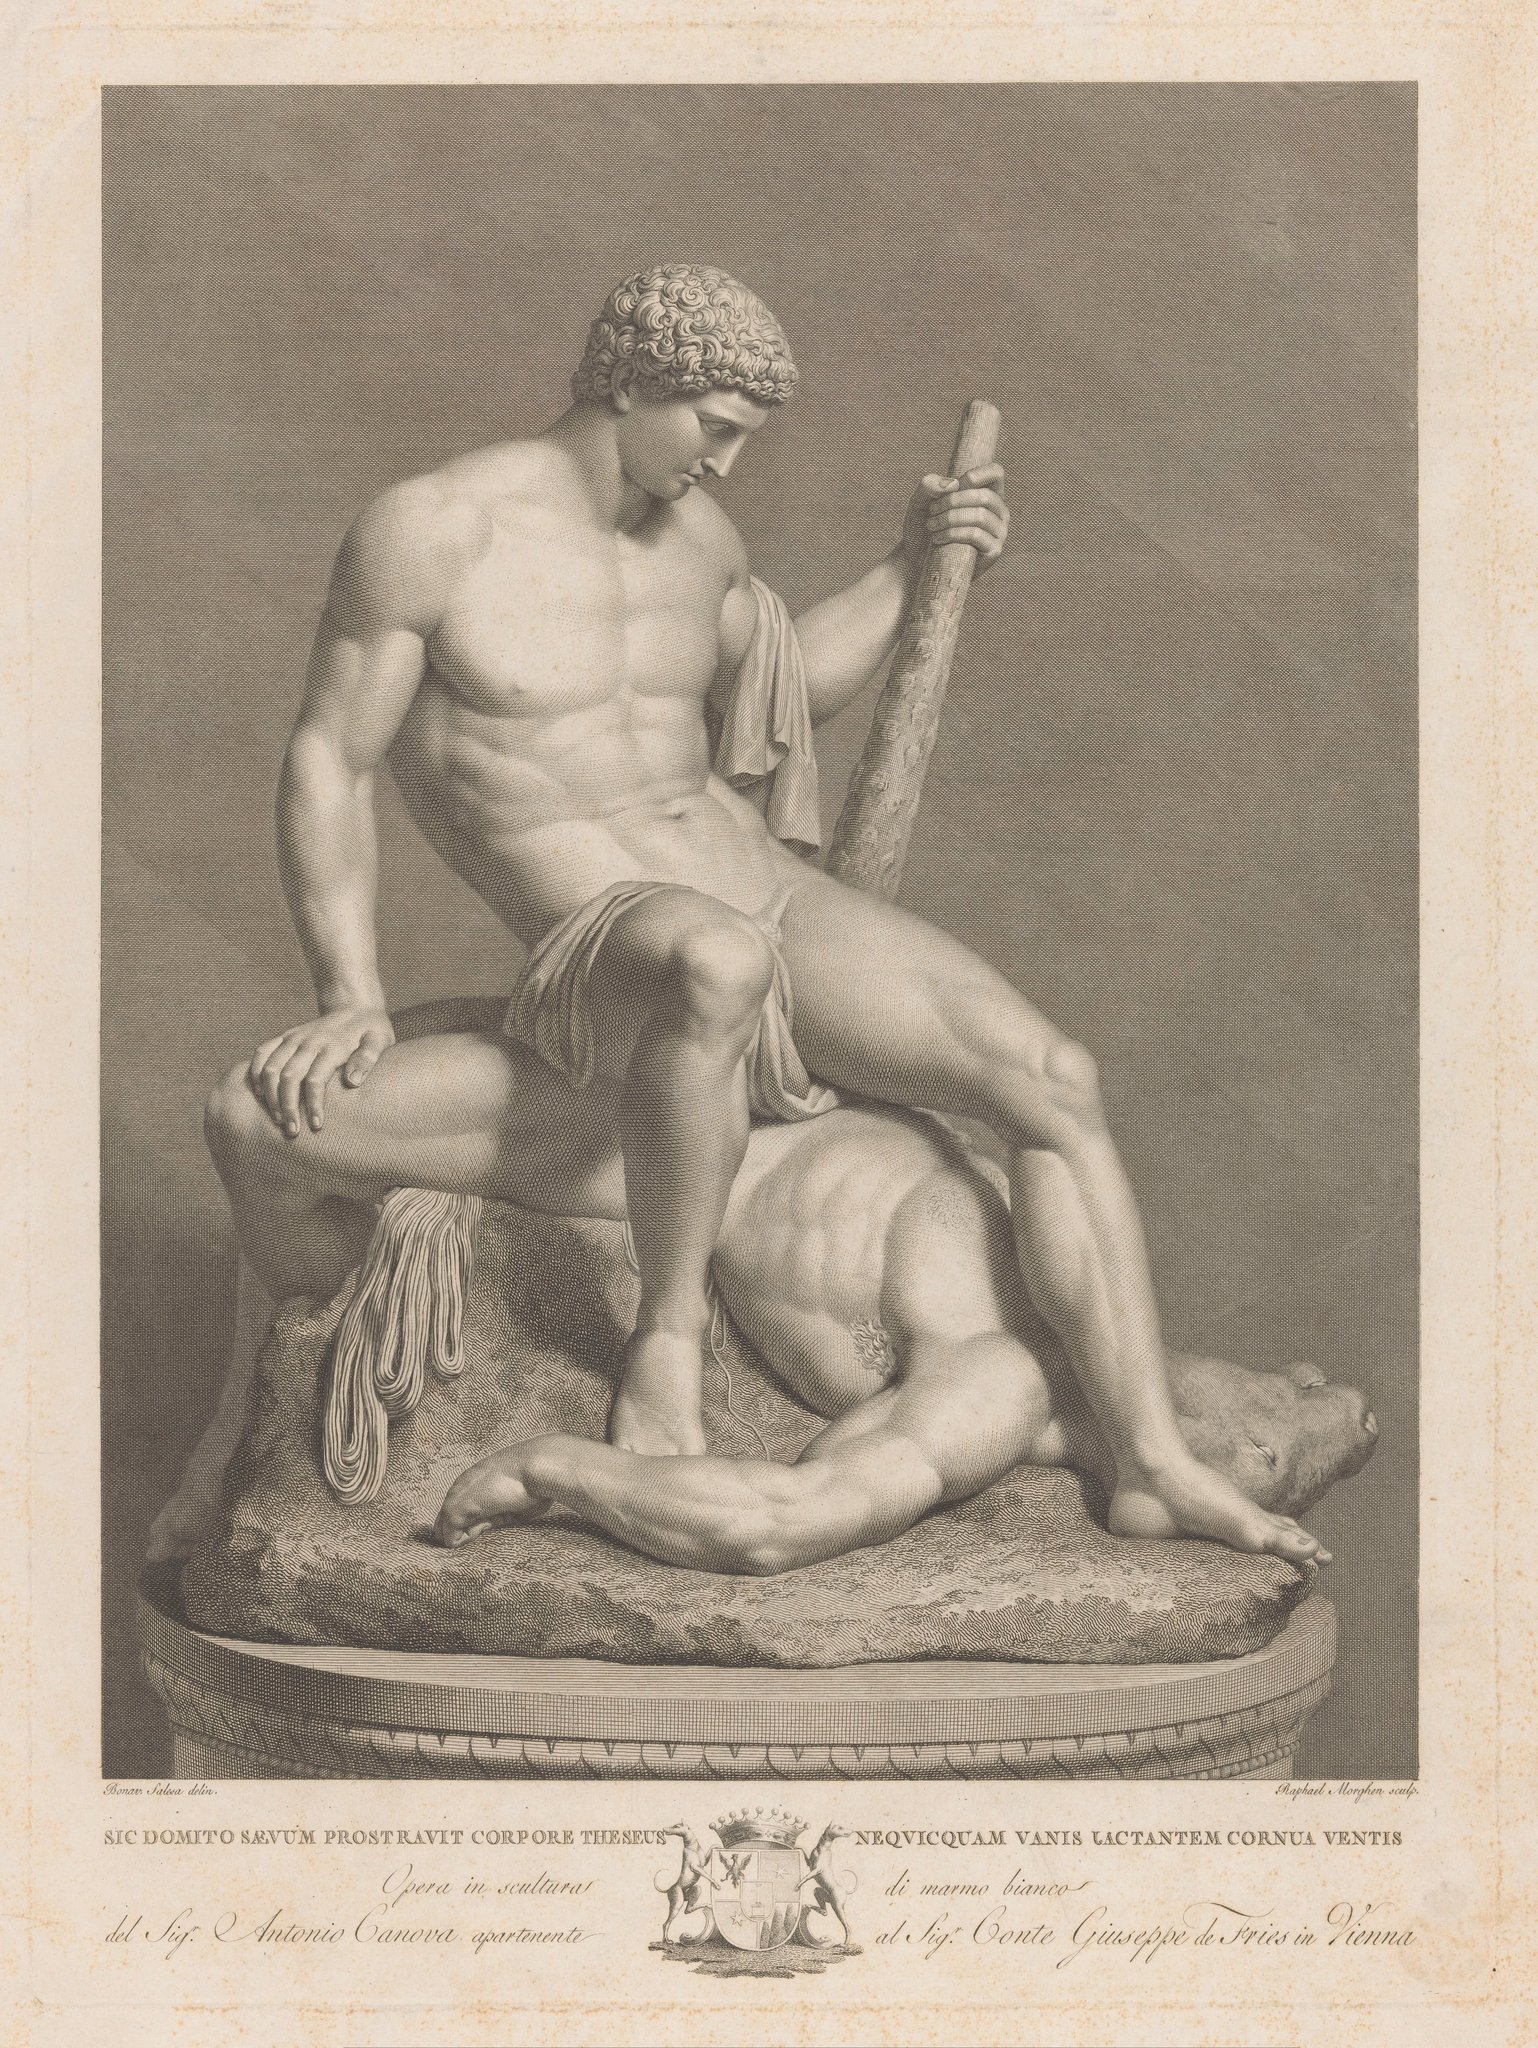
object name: print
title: Theseus en de Minotaurus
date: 1768-1833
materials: paper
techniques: engraving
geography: italy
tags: theseus kills the minotaur, piece of sculpture, reproduction of a piece of sculpture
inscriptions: collector's mark: Lugt 12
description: Een sculptuur van Theseus die op de zojuist veslagen Minotaurus zit, door de Italiaanse beeldhouwer Antonio Canova.